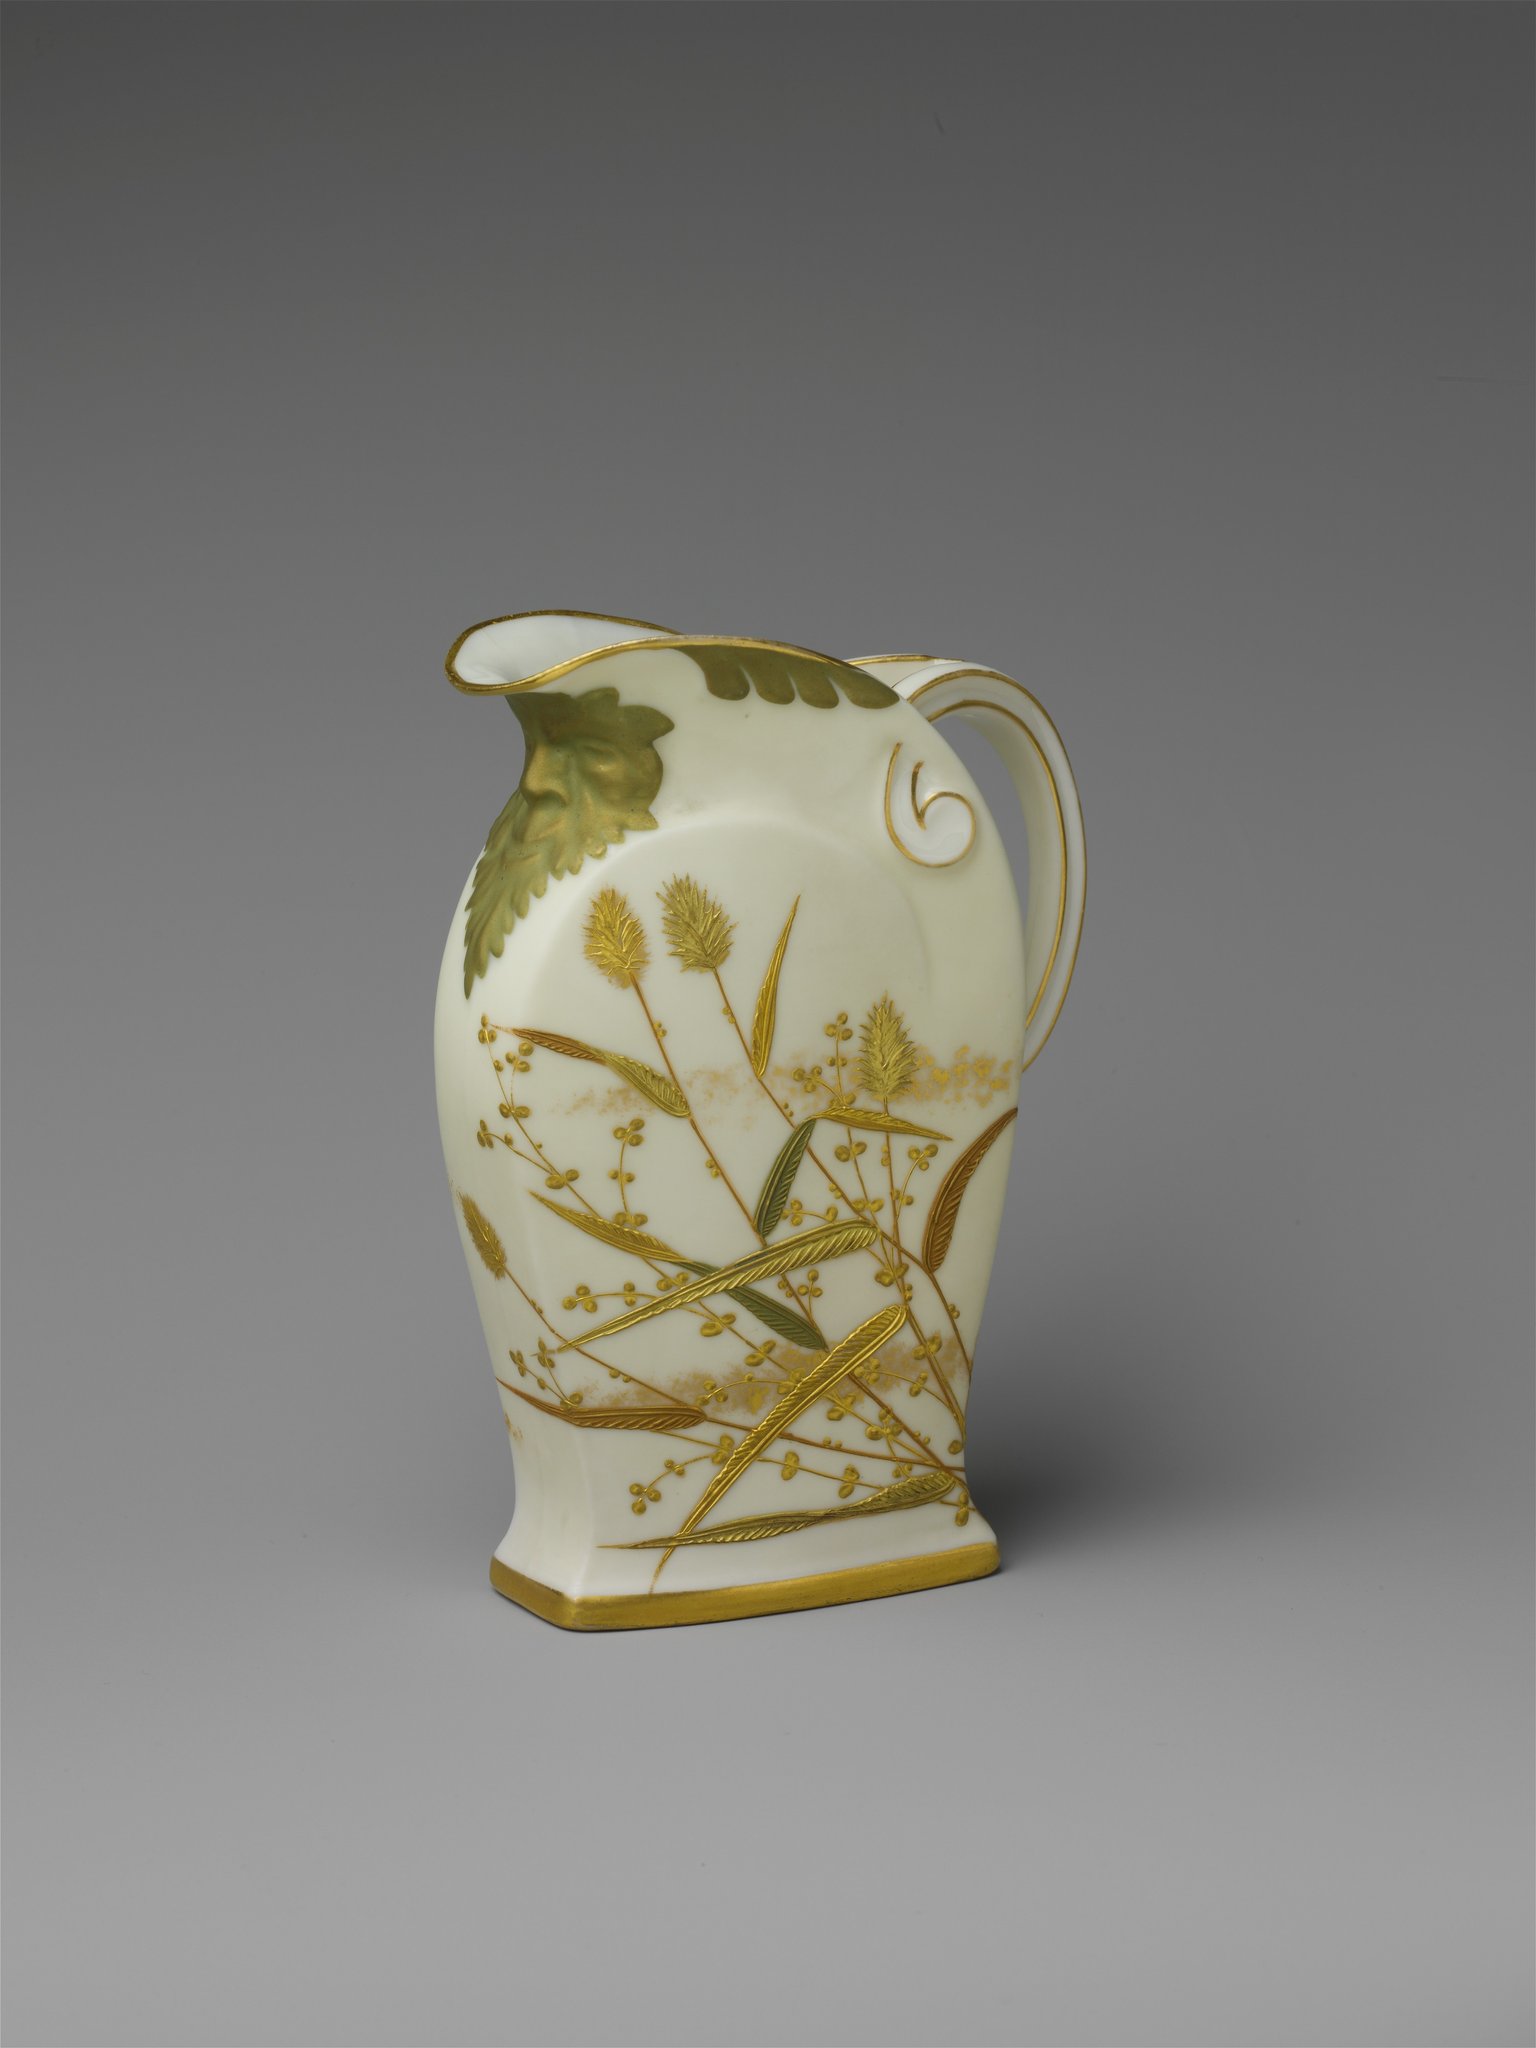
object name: pitcher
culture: american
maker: ott and brewer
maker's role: maker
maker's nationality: american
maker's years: 1871-1893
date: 1880-1890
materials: porcelain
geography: united states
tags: plants